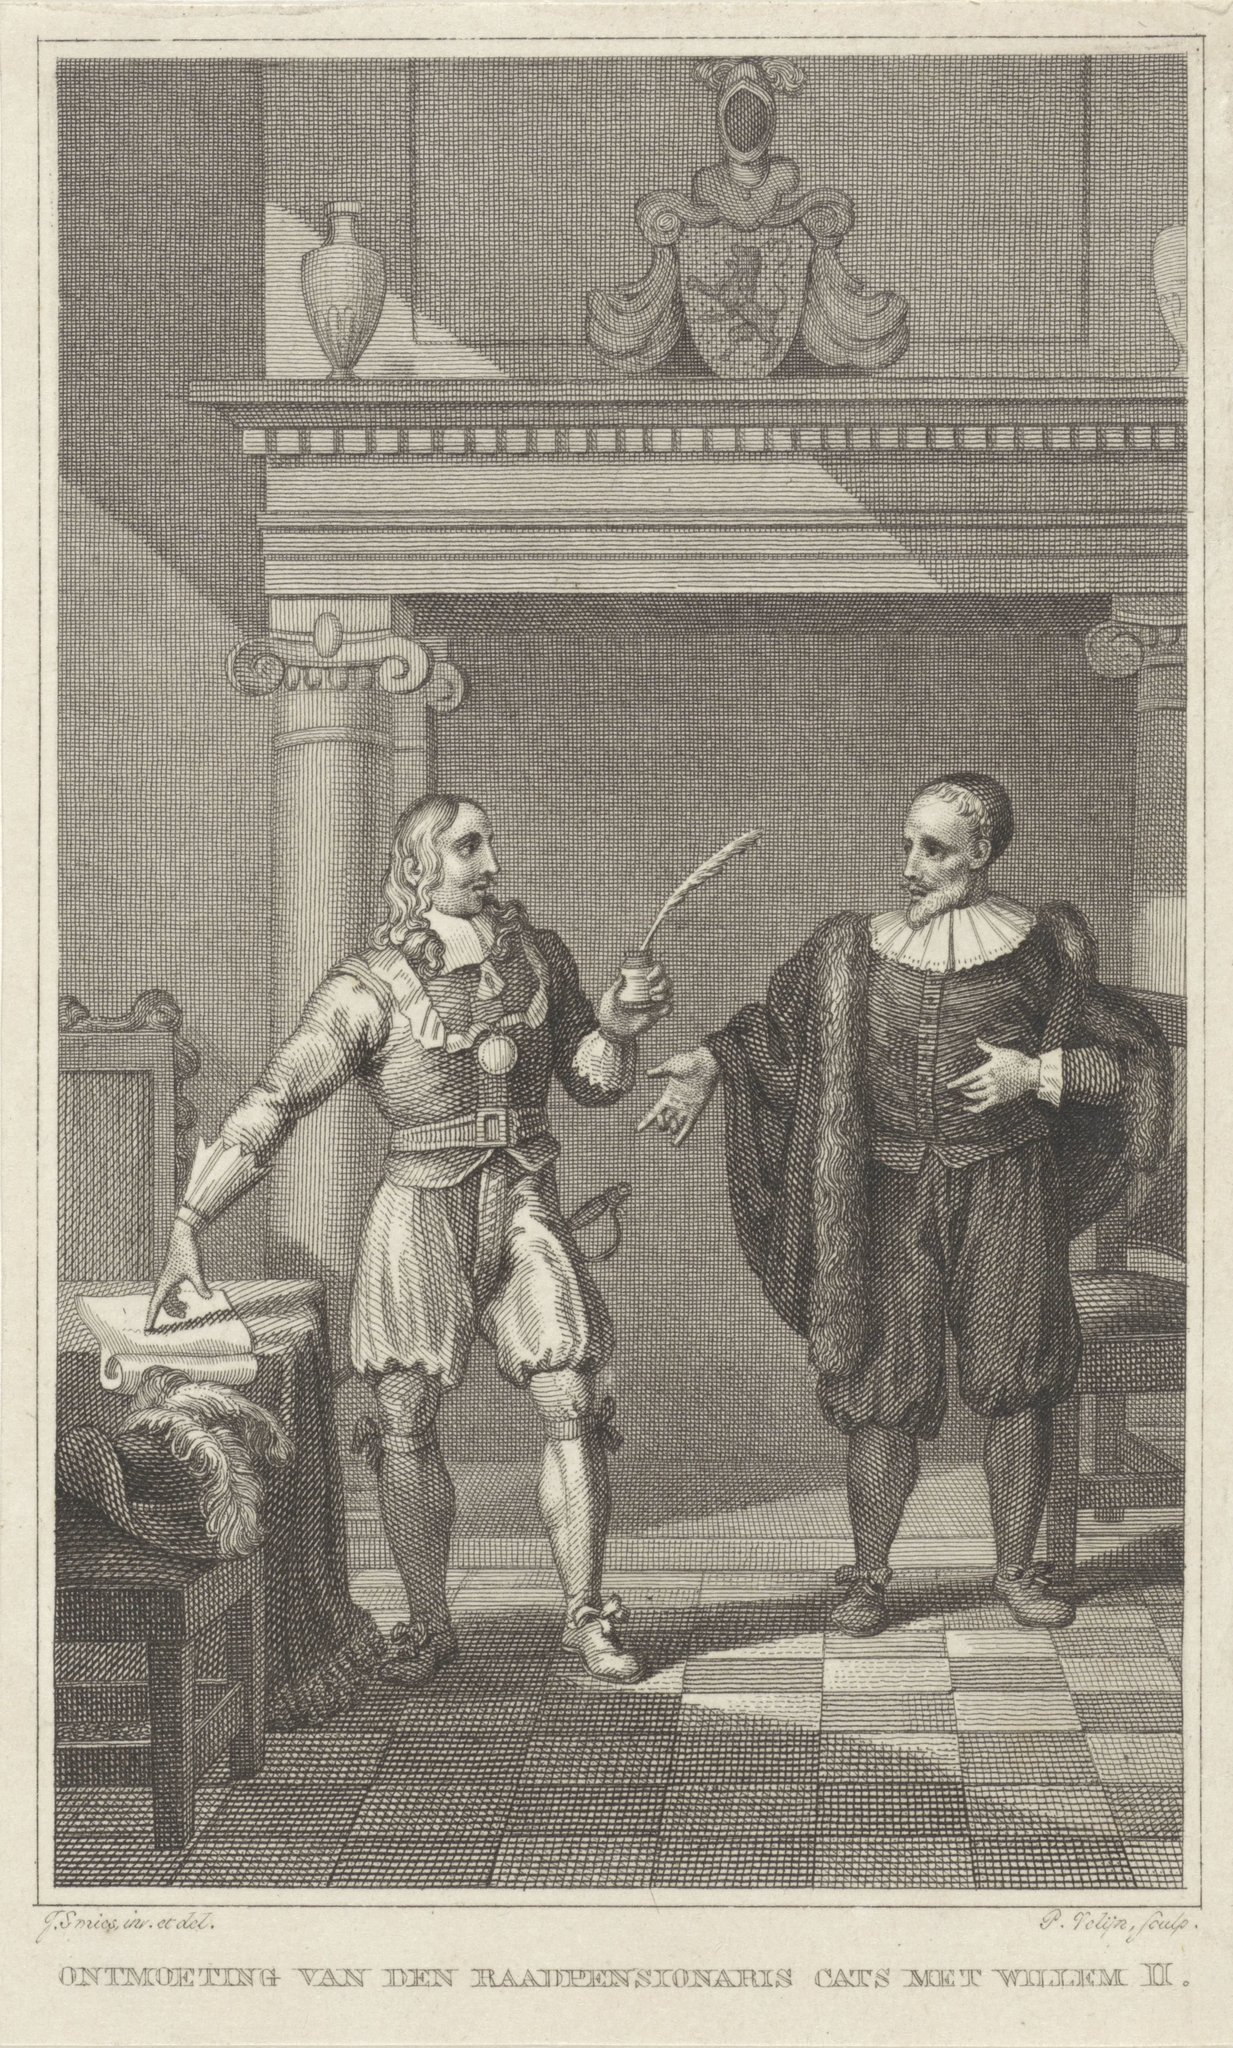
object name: book illustration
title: Ontmoeting van den raadpensionaris Cats met Willem II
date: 1828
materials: paper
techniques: engraving, etching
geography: netherlands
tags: william ii (prince of orange), the hague, jacob cats (1577-1660), quill, paper (writing material), index finger forwards, pointing, indicating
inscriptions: collector's mark: Lugt 2228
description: Prent gebruikt in: Witsen Geysbeek, P. G. en G. Engelberts Gerrits. Schoonheden en merkwaardige tafereelen uit de Nederlandsche geschiedenis. Amsterdam: G. Portielje, 1825-1829. Zesde deel, 1828.